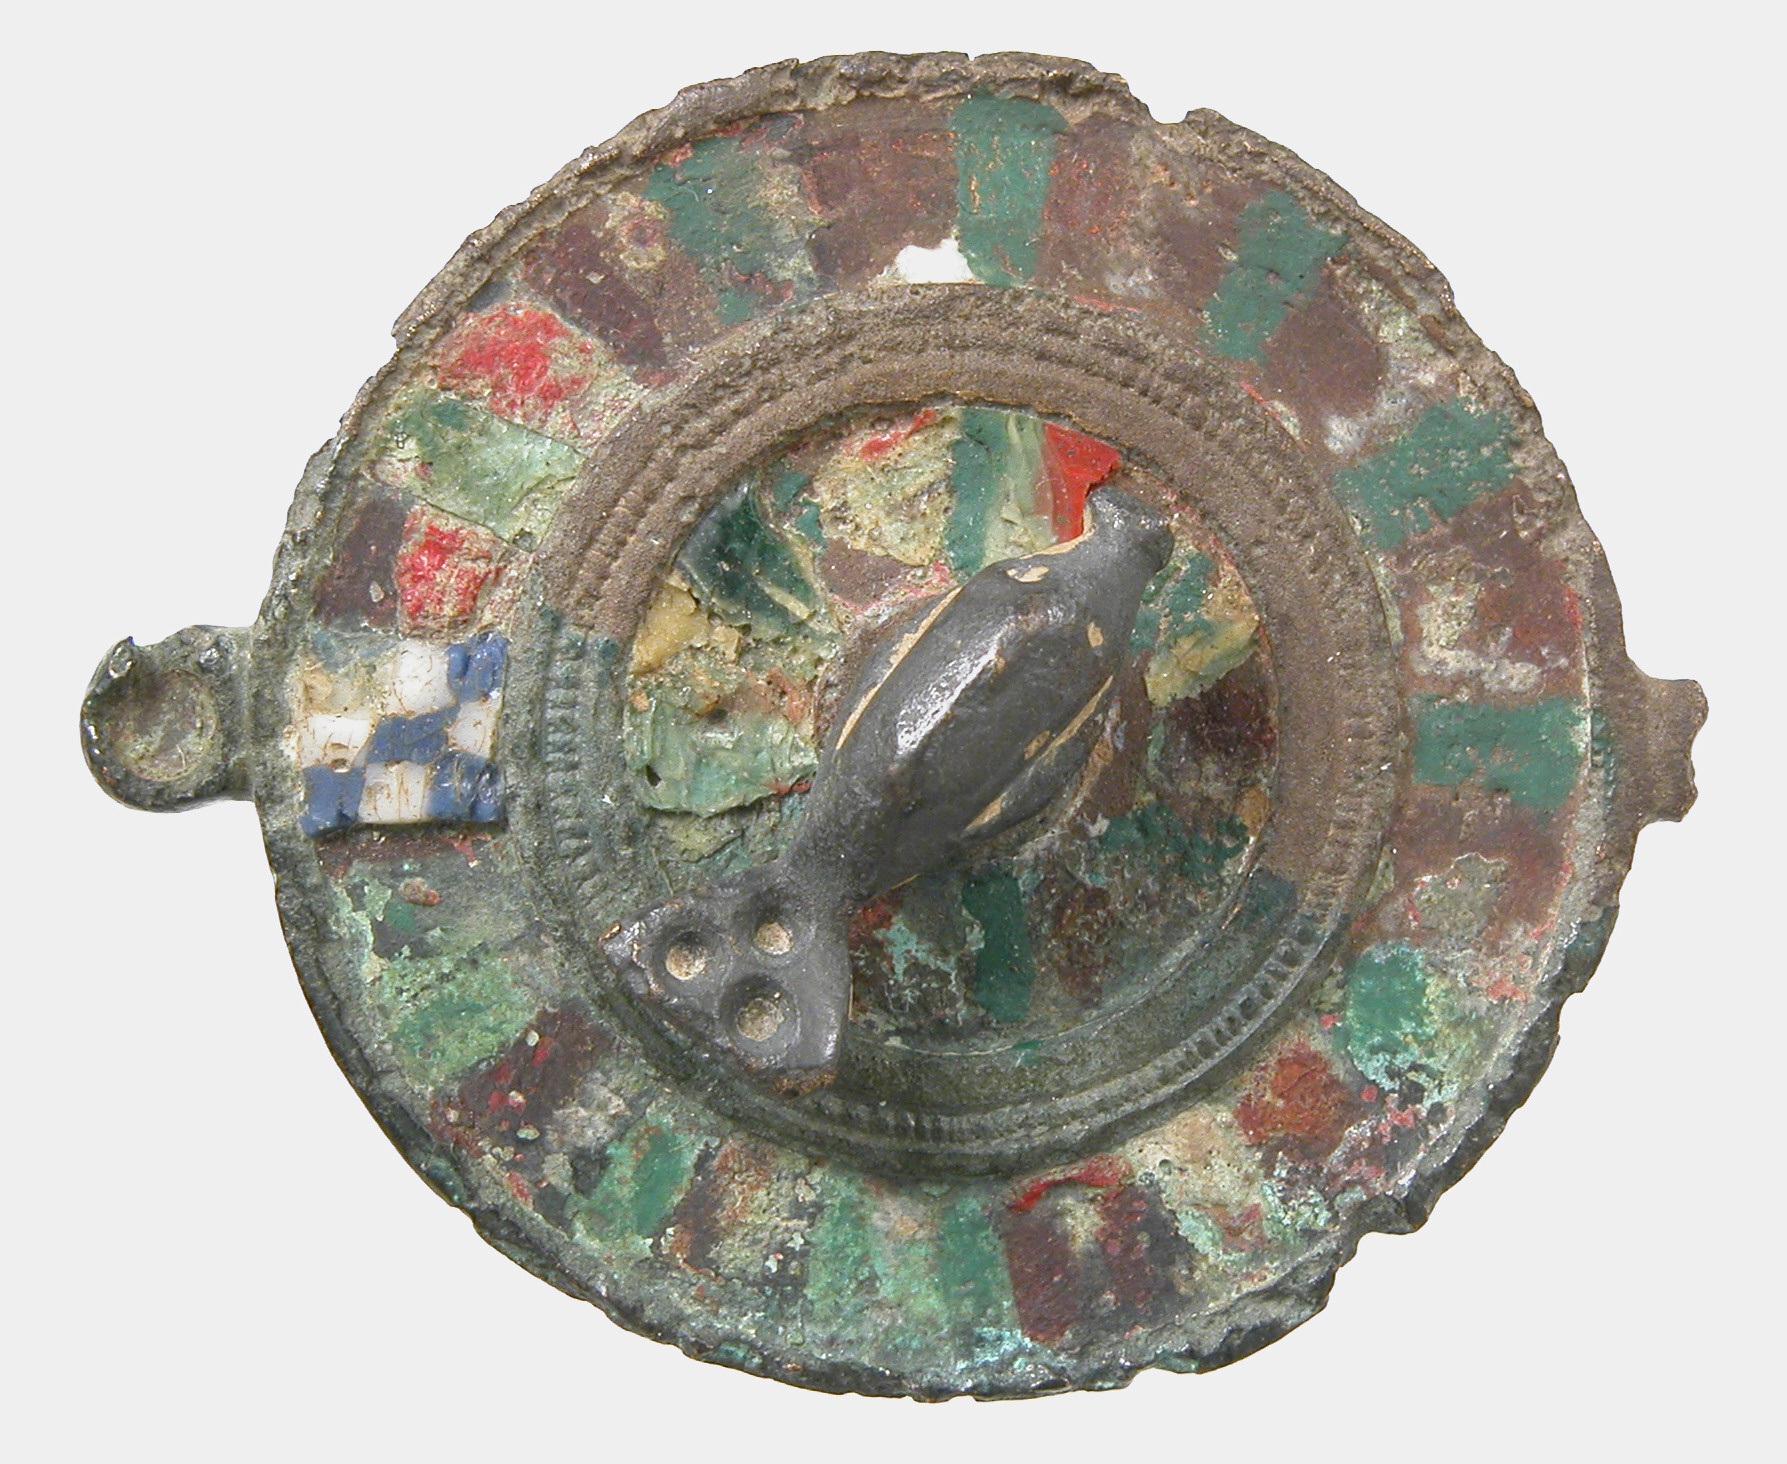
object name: brooch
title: Disk Brooch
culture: roman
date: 201-300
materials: copper alloy, enamel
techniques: enamel